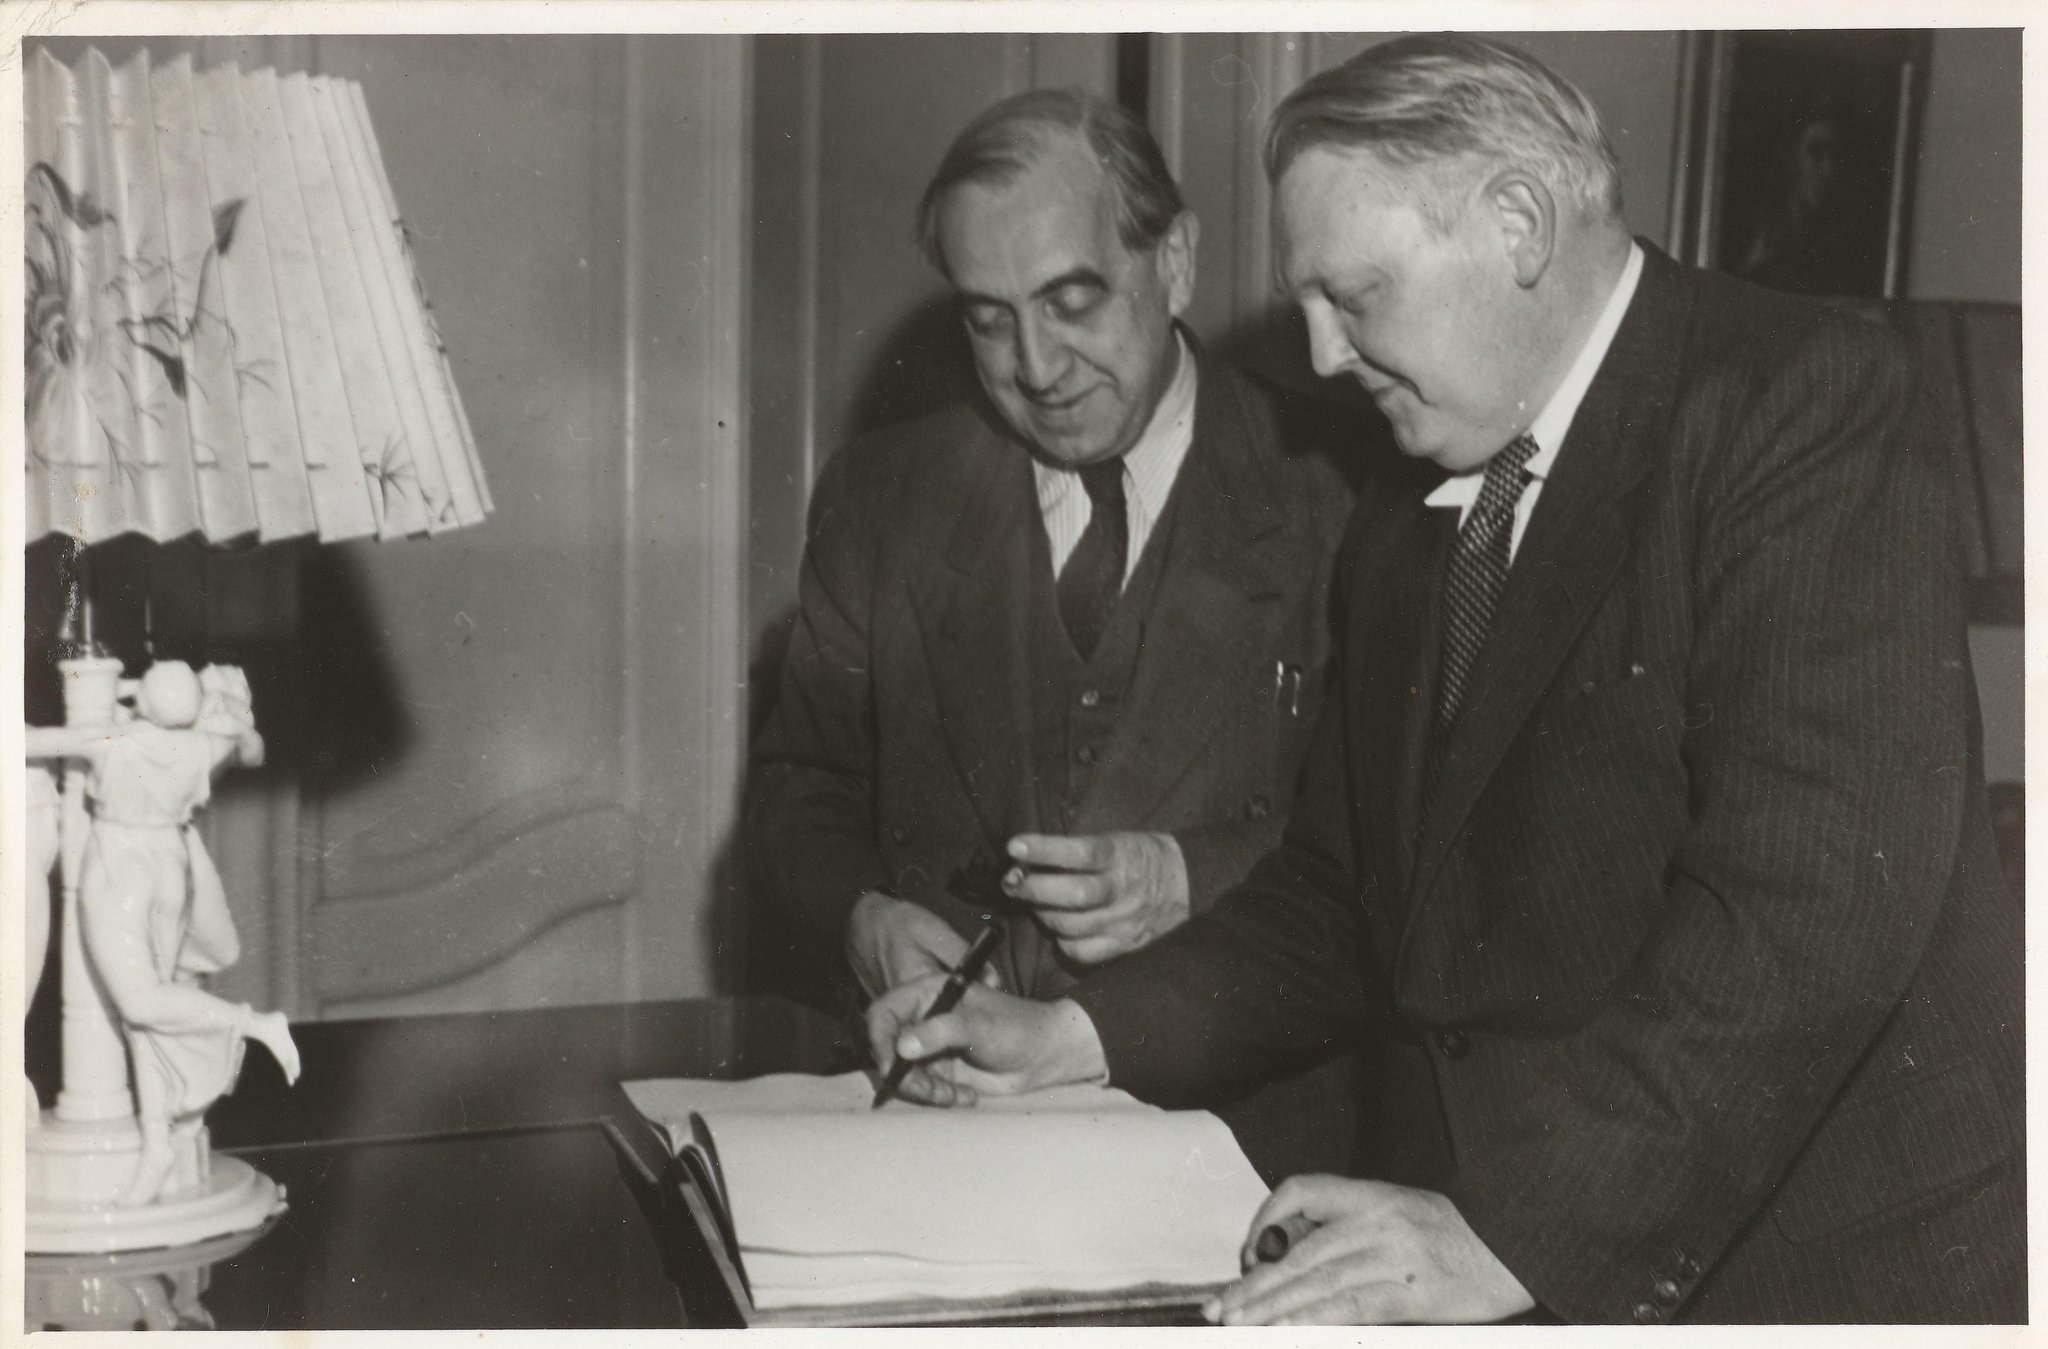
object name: photograph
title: Prof. Ehrhard signeert het gastenboek van de stad Berlijn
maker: Anonymous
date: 1949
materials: photographic support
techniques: gelatin silver print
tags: berlin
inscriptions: annotation: ‘Prof. Erhard, director of the administraion for economy...’